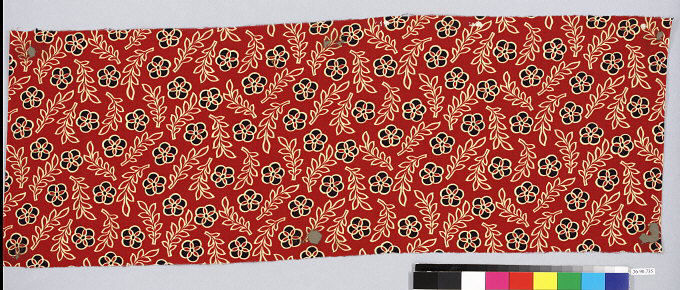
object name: piece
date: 1867-1900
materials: cotton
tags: flowers,leaves